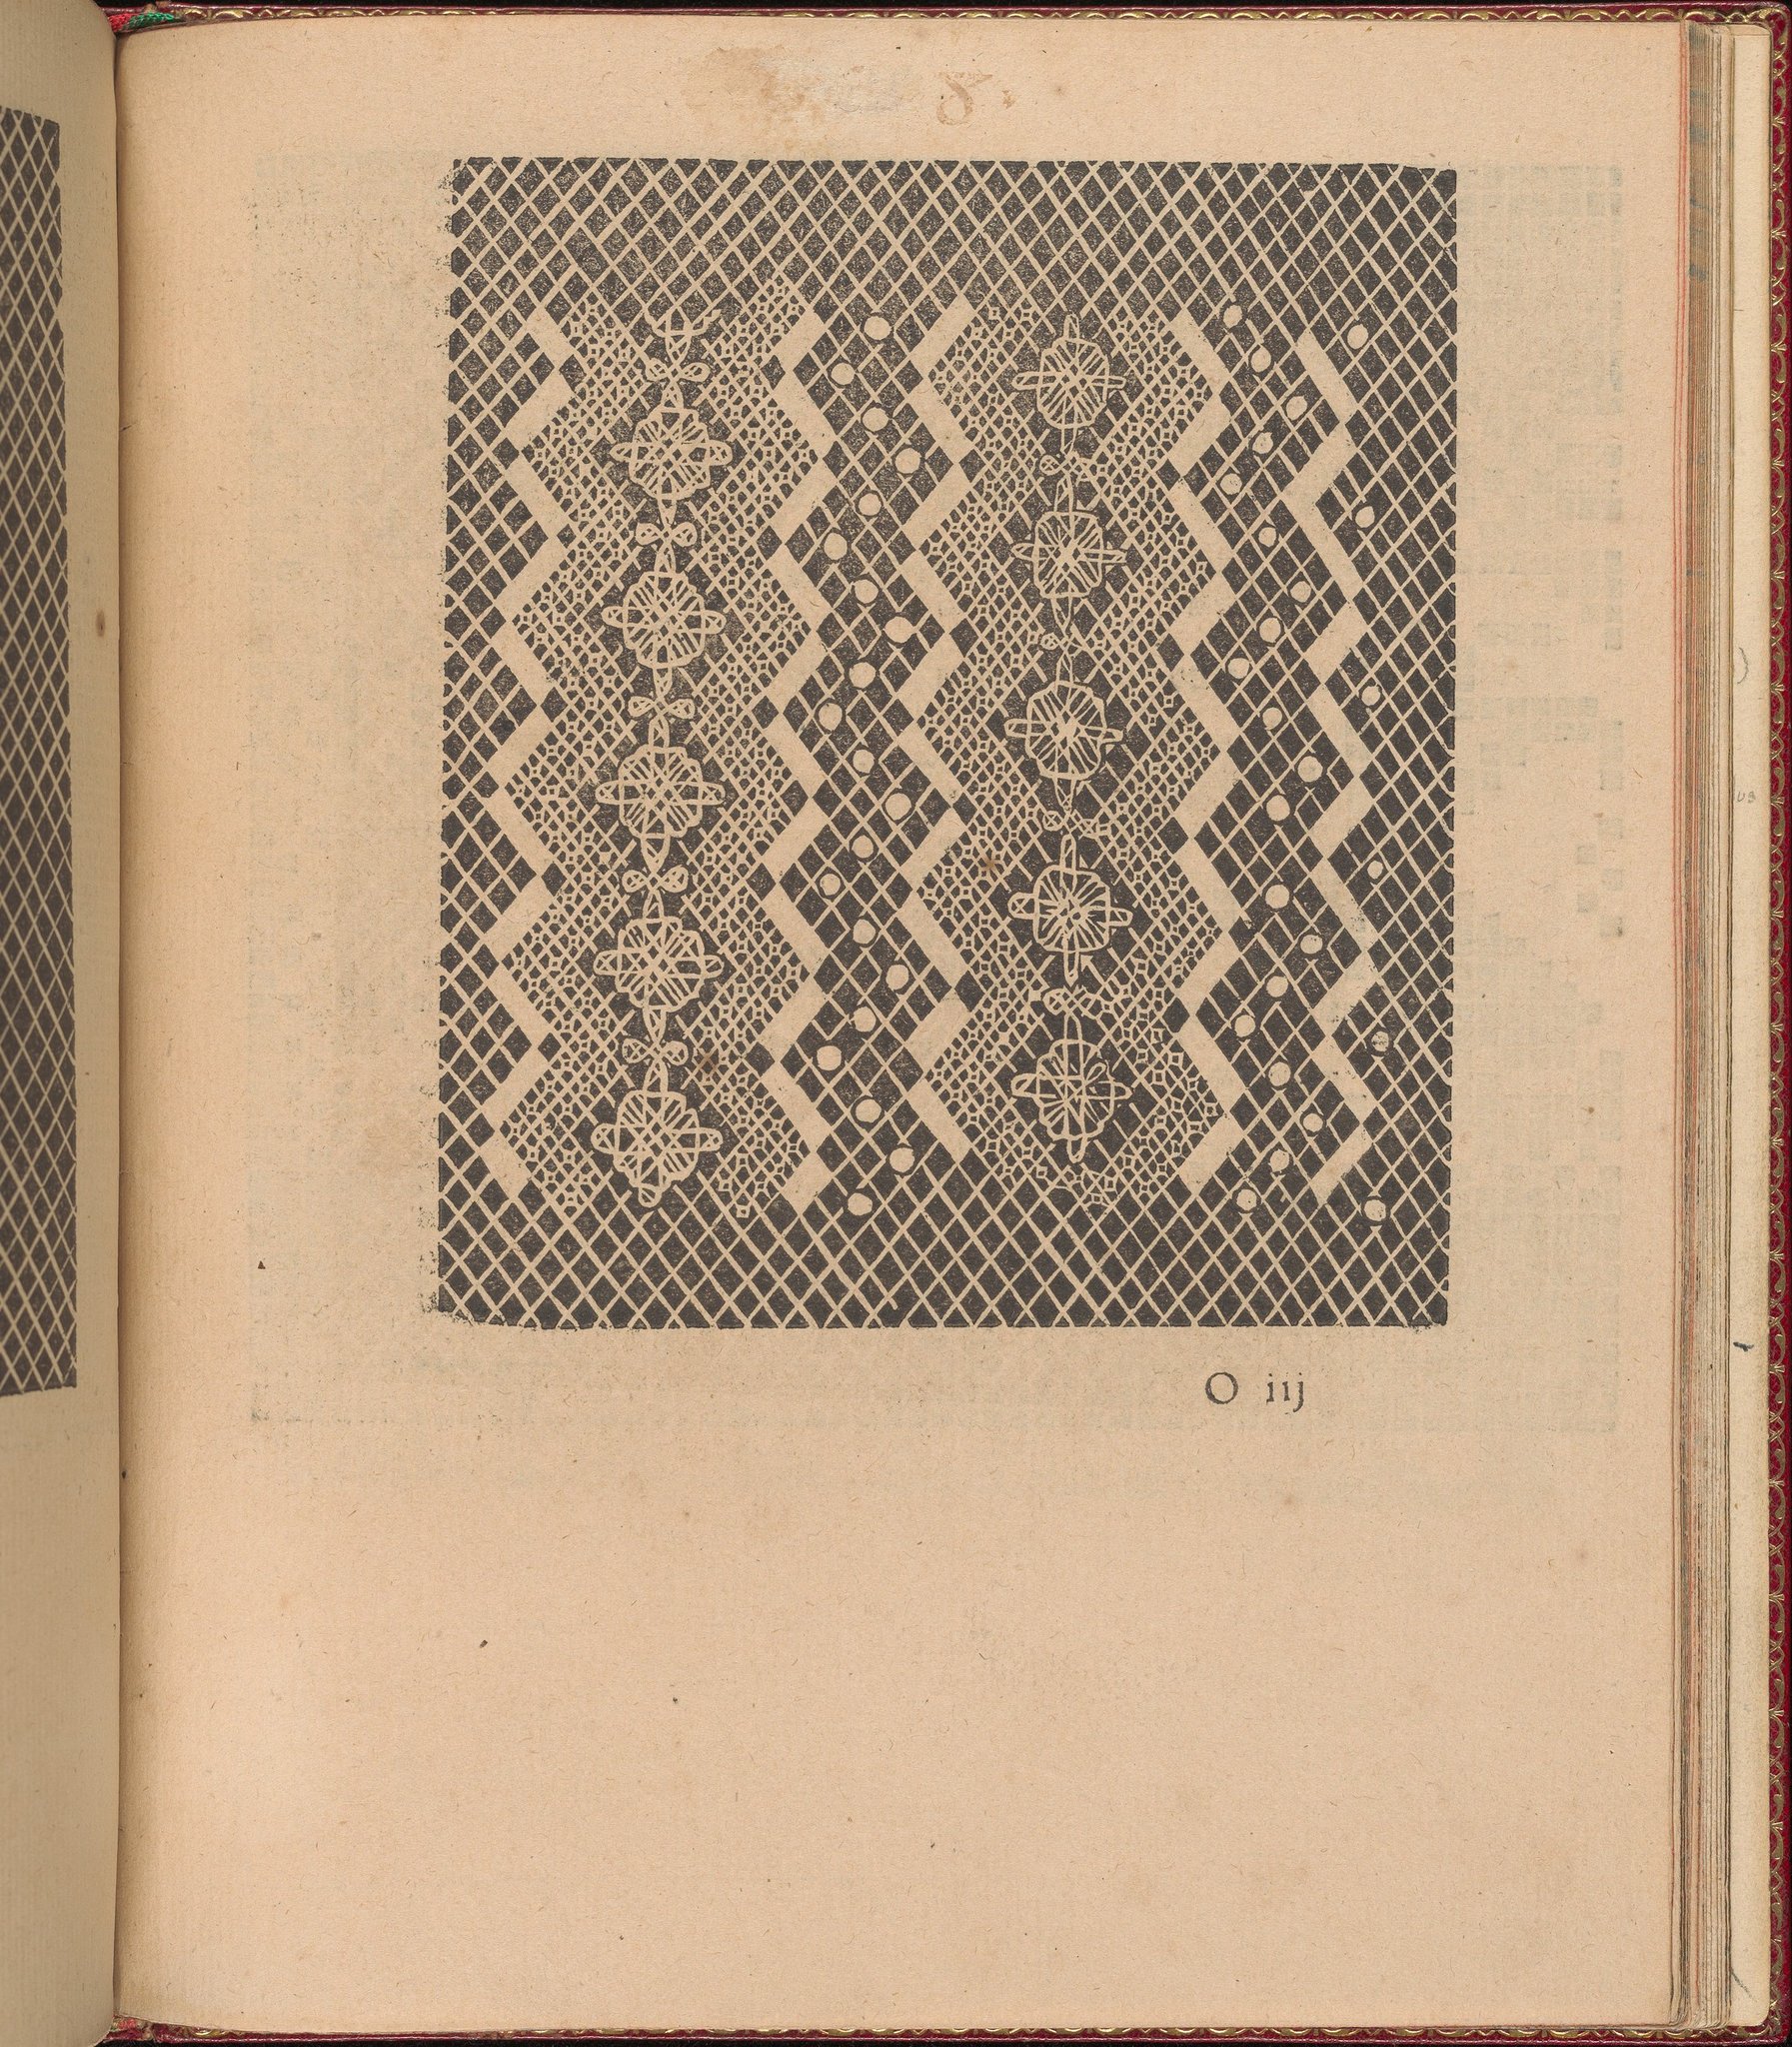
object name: book print ornament architecture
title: Les Singuliers et Nouveaux Portraicts... page 55 (recto)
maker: federico de vinciolo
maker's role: designer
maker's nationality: italian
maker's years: 1582-1599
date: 1588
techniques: woodcut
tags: ornament